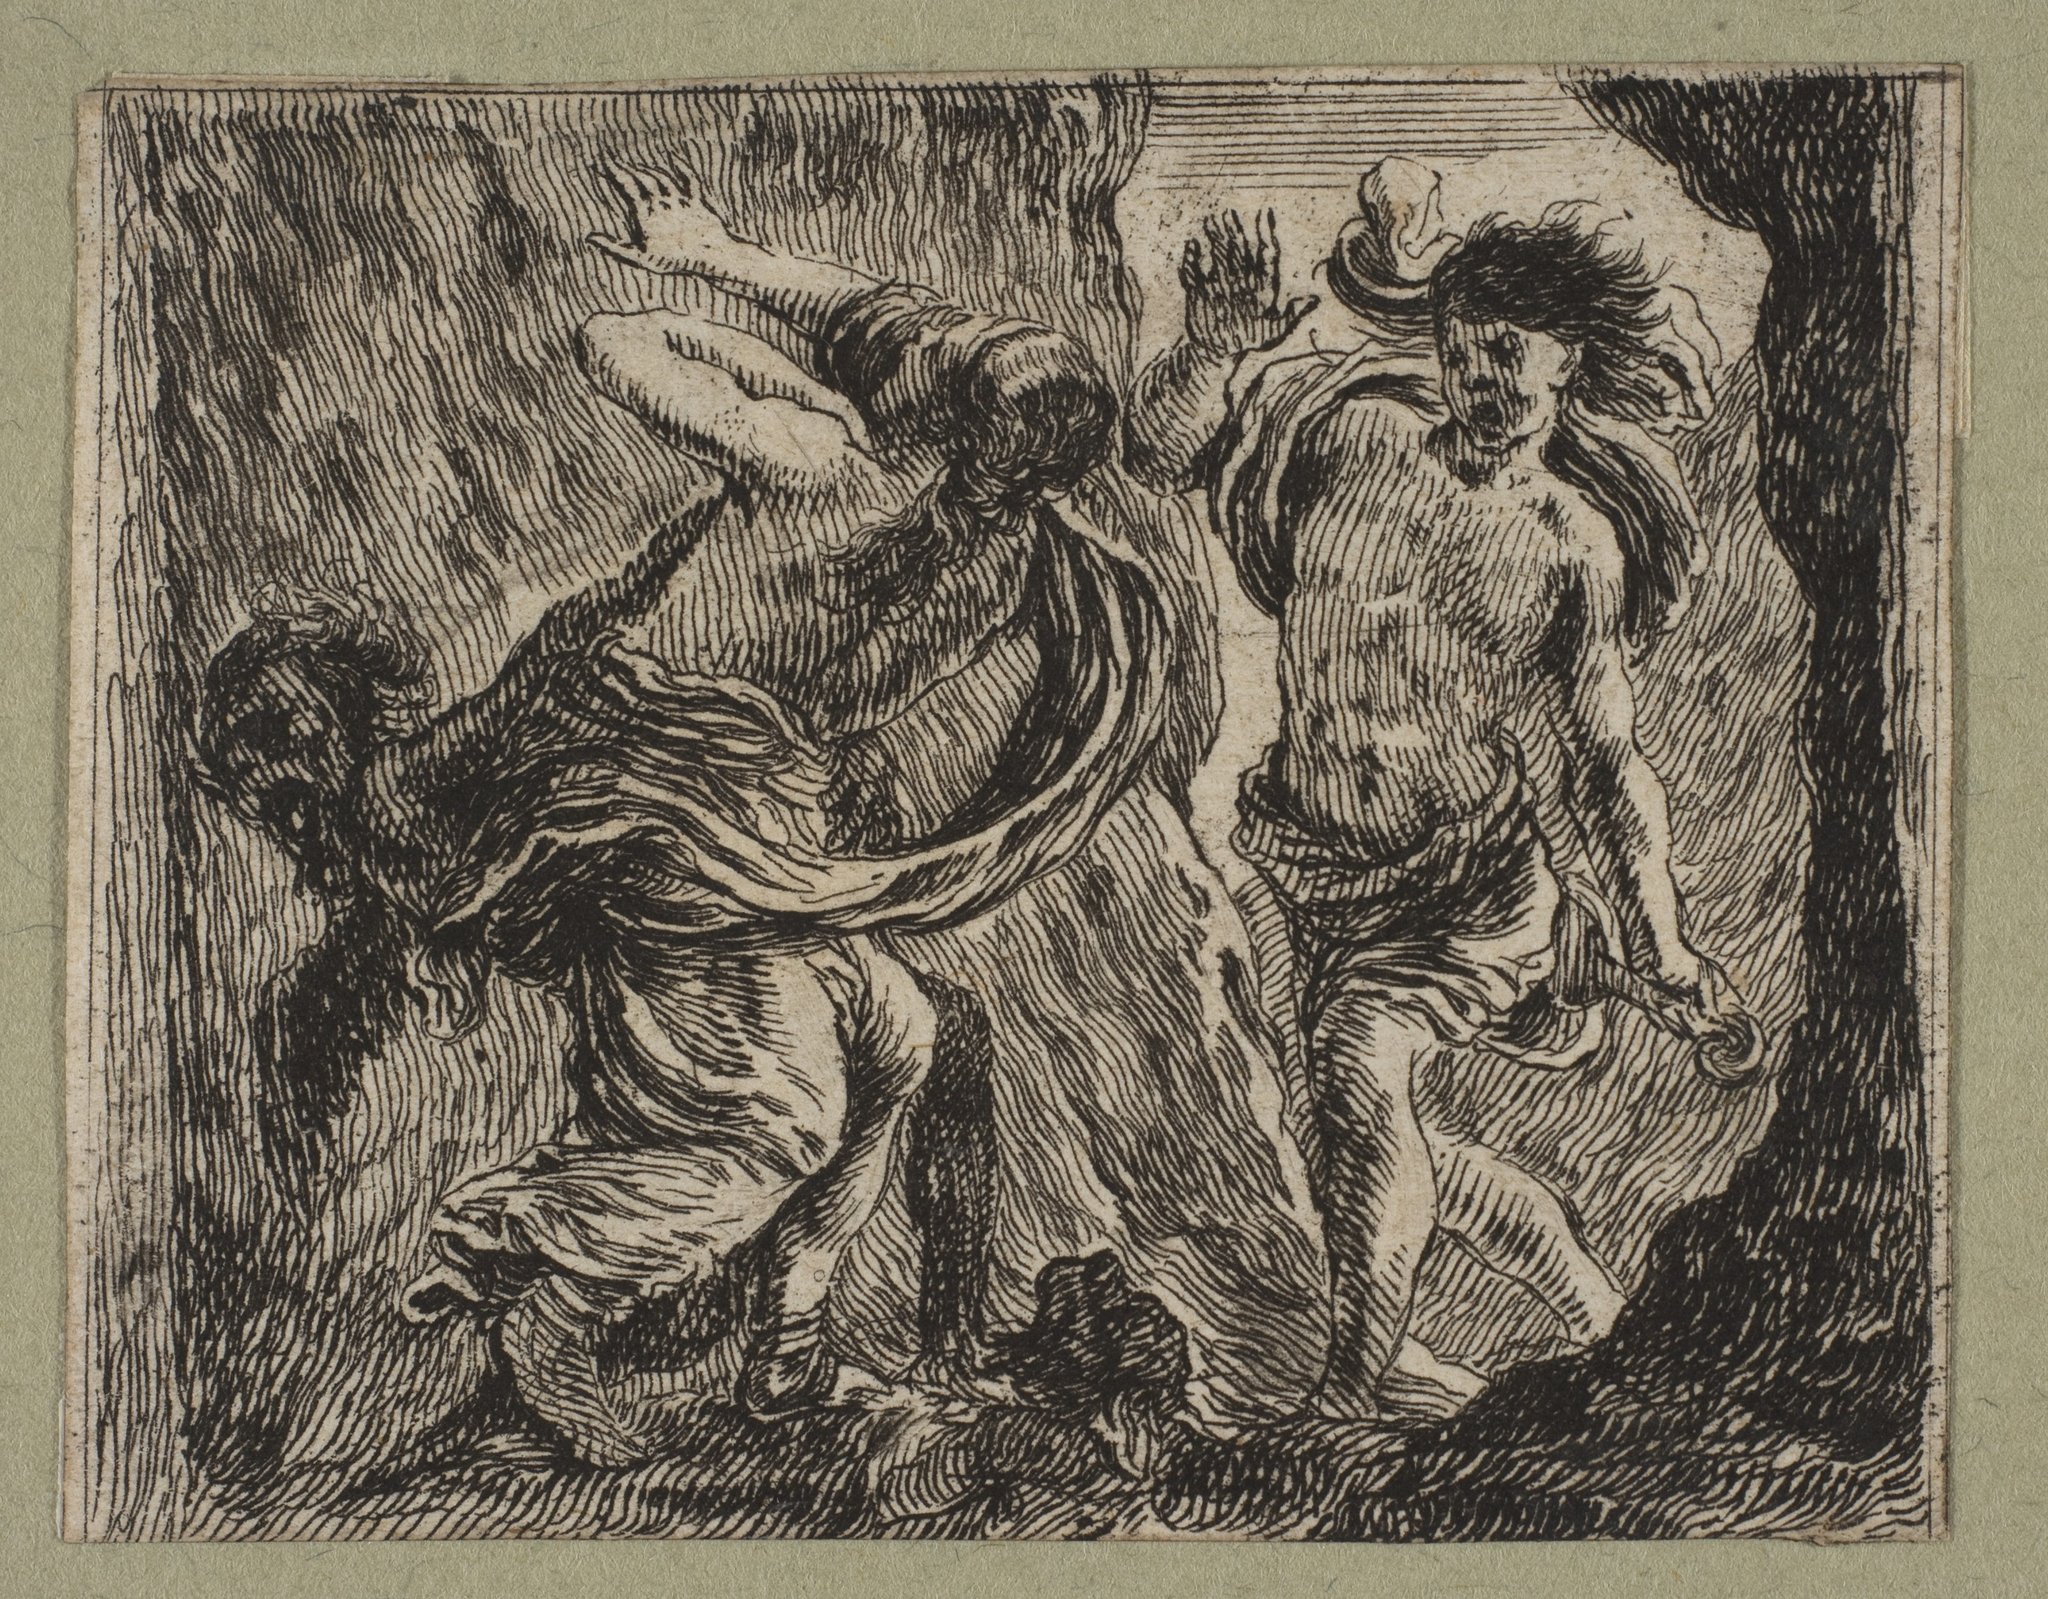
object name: print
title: Orphée et Eurydice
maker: stefano della bella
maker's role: artist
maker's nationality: italian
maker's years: 1610-1664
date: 1644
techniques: etching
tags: men,women,orpheus,eurydice